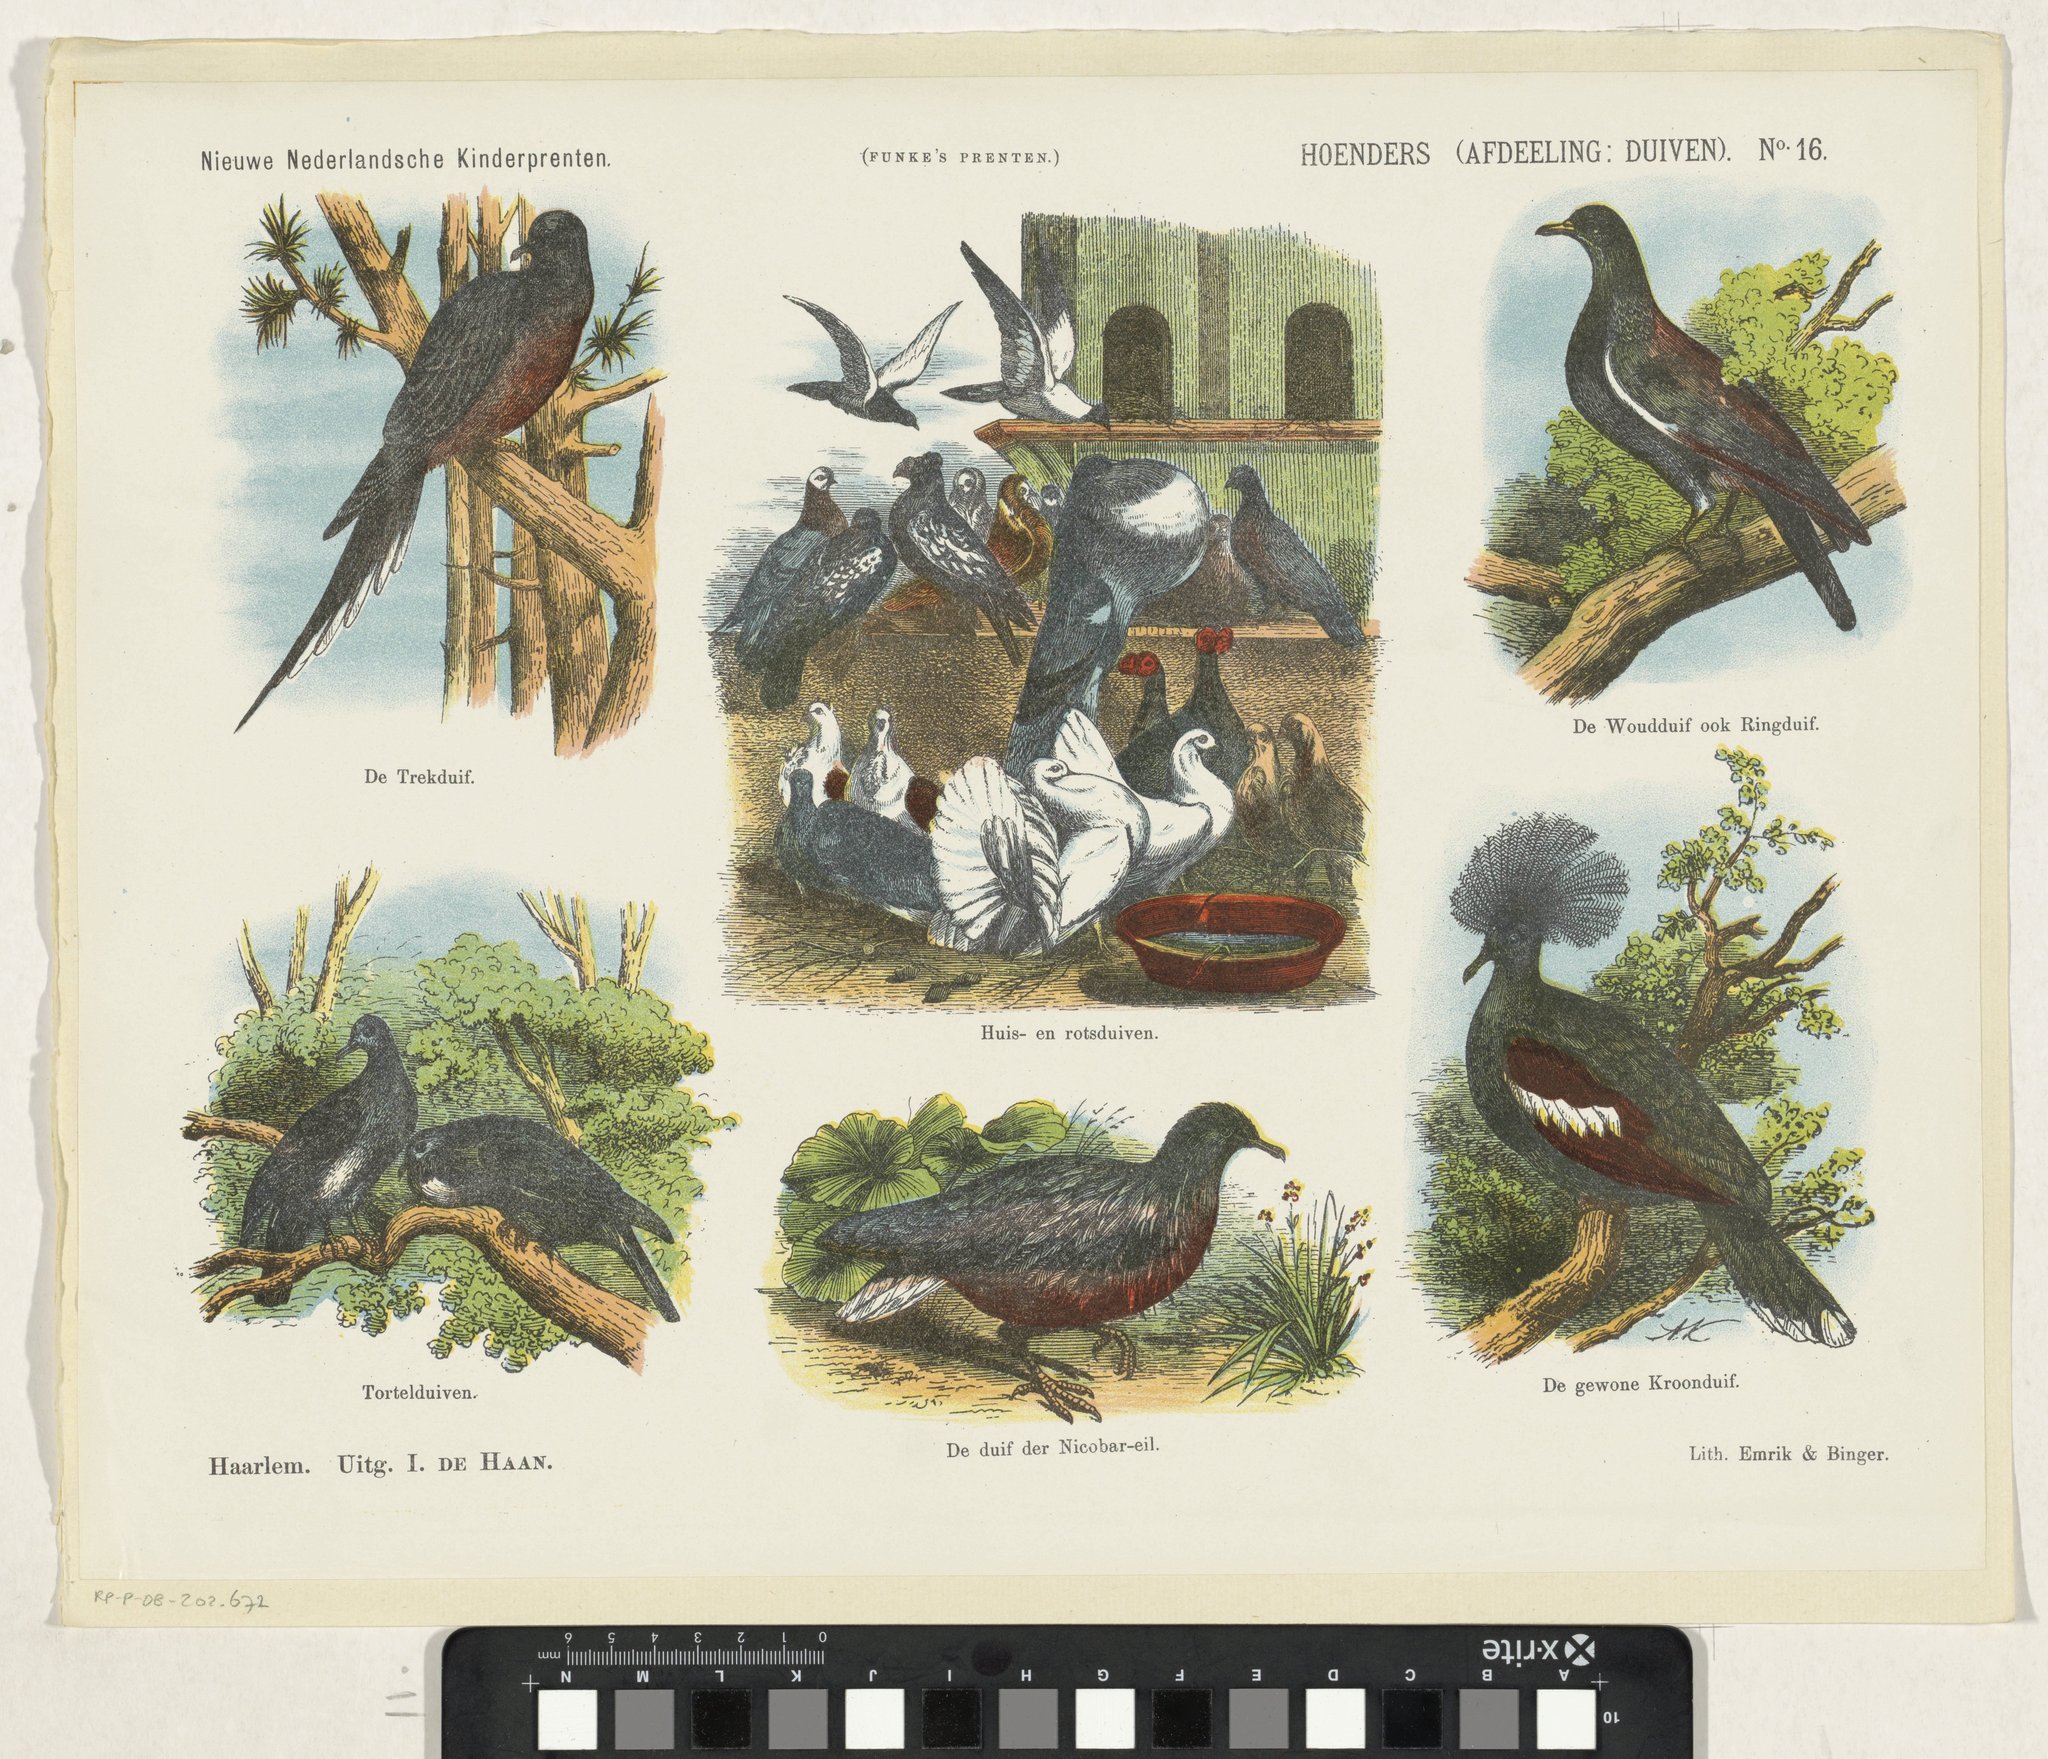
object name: print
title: Nieuwe Nederlandsche kinderprenten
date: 1875-1903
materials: paper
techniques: lithograph, letterpress printing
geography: haarlem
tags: birds, doves, pigeons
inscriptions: collector's mark: Lugt 2760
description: Blad met 6 voorstellingen van verschillende duiven, onder andere een trekduif en een kroonduif. Onder elke voorstelling een onderschrift. Genummerd rechtsboven: No. 16.